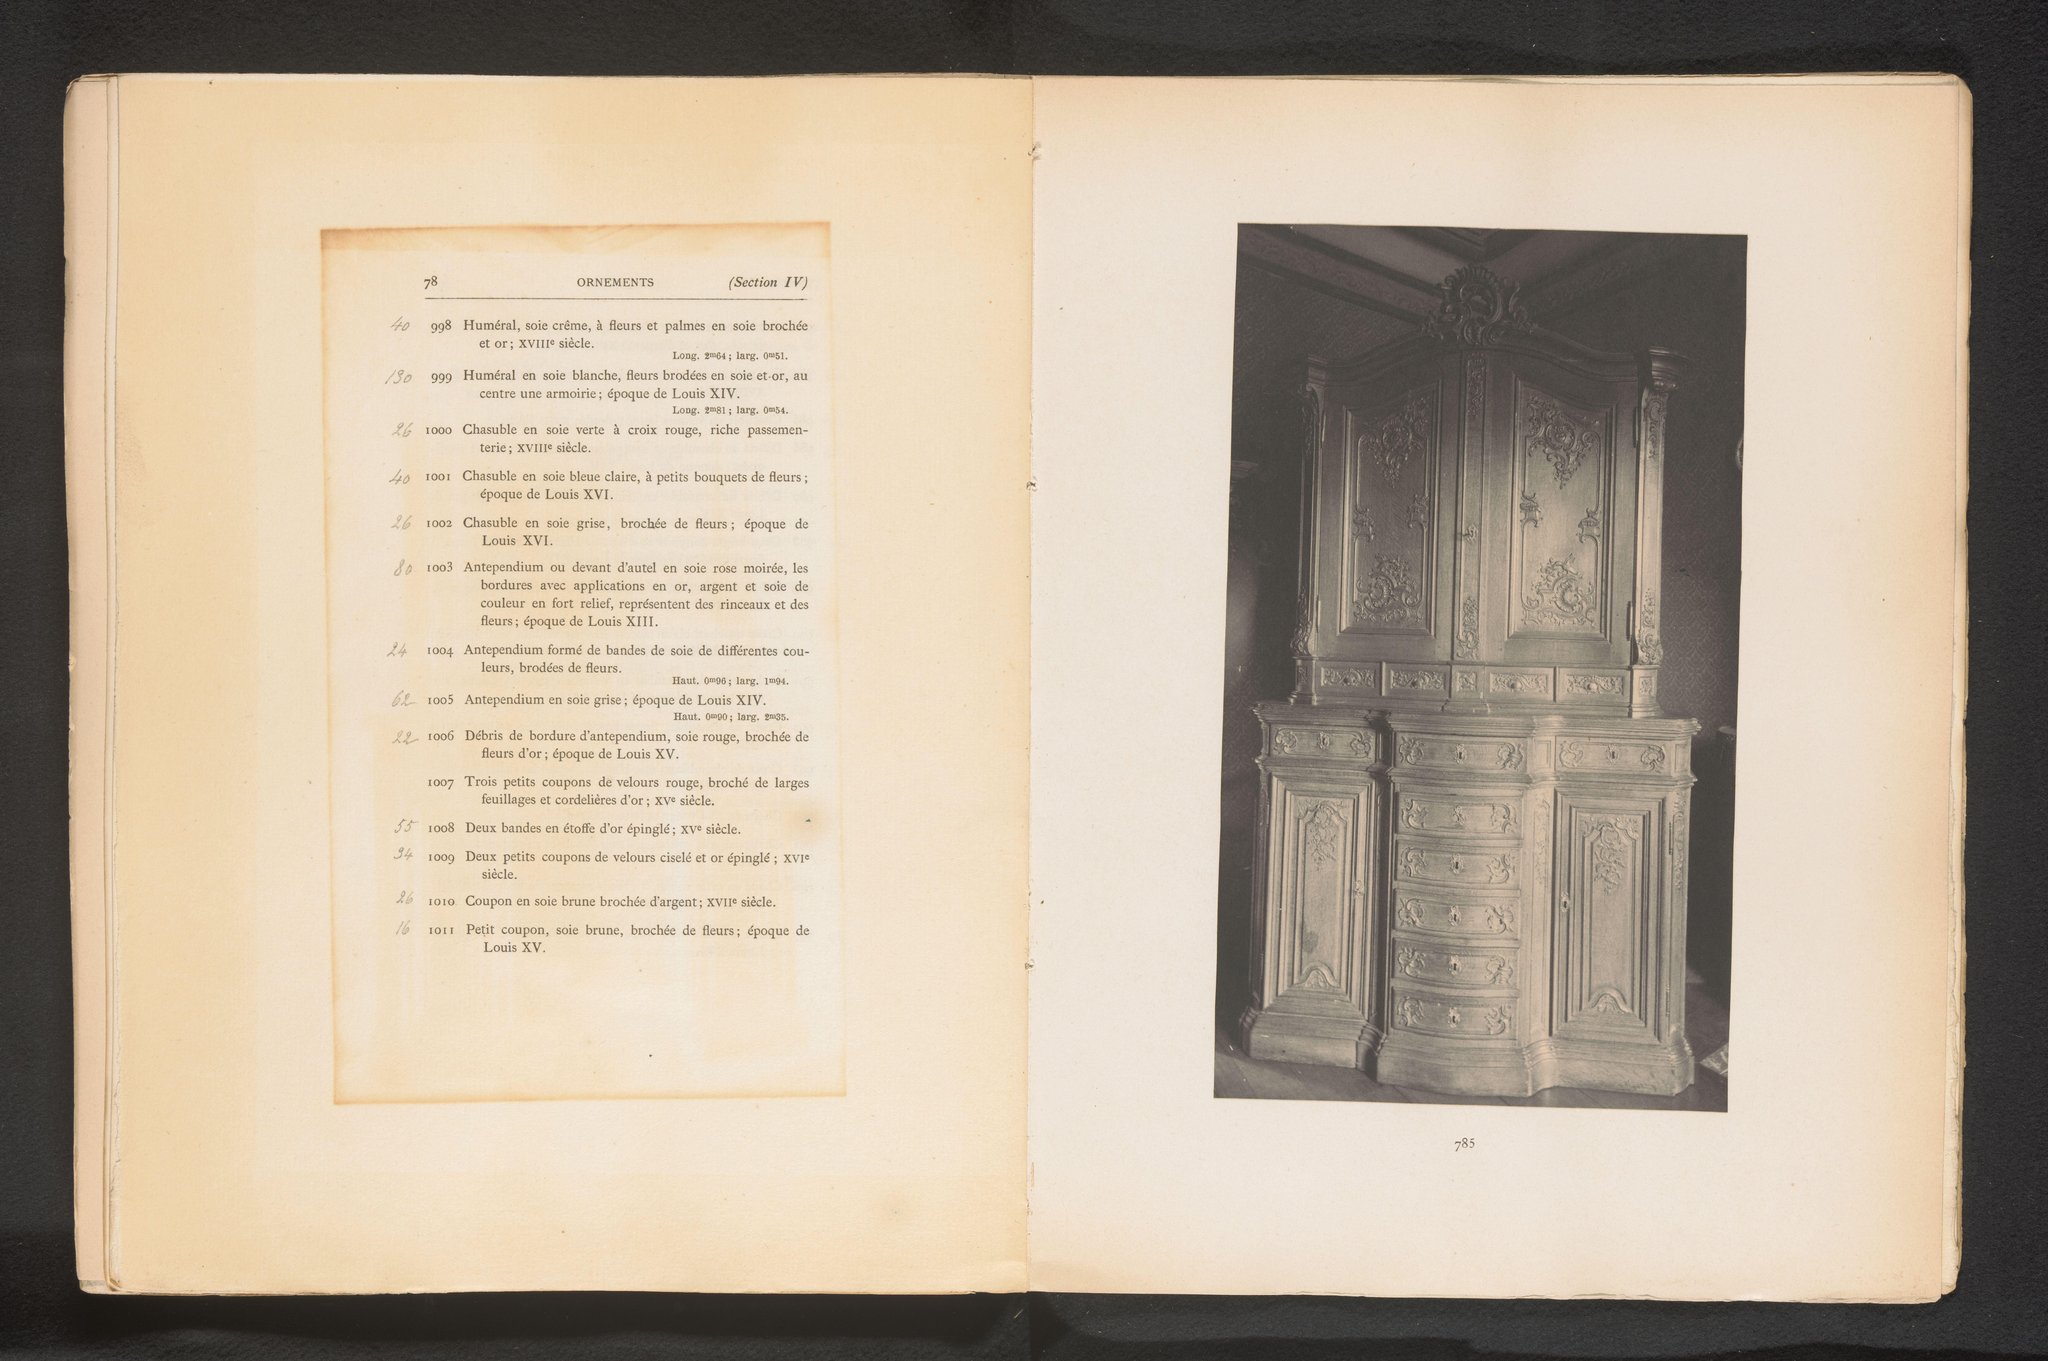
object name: page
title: Gedecoreerde kast uit de collectie van Antonin Terme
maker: Anonymous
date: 1880-1885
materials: photographic support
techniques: platinum process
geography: liège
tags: art collection, art gallery, cabinet of curiosities, 'kunst- und wunderkammer'